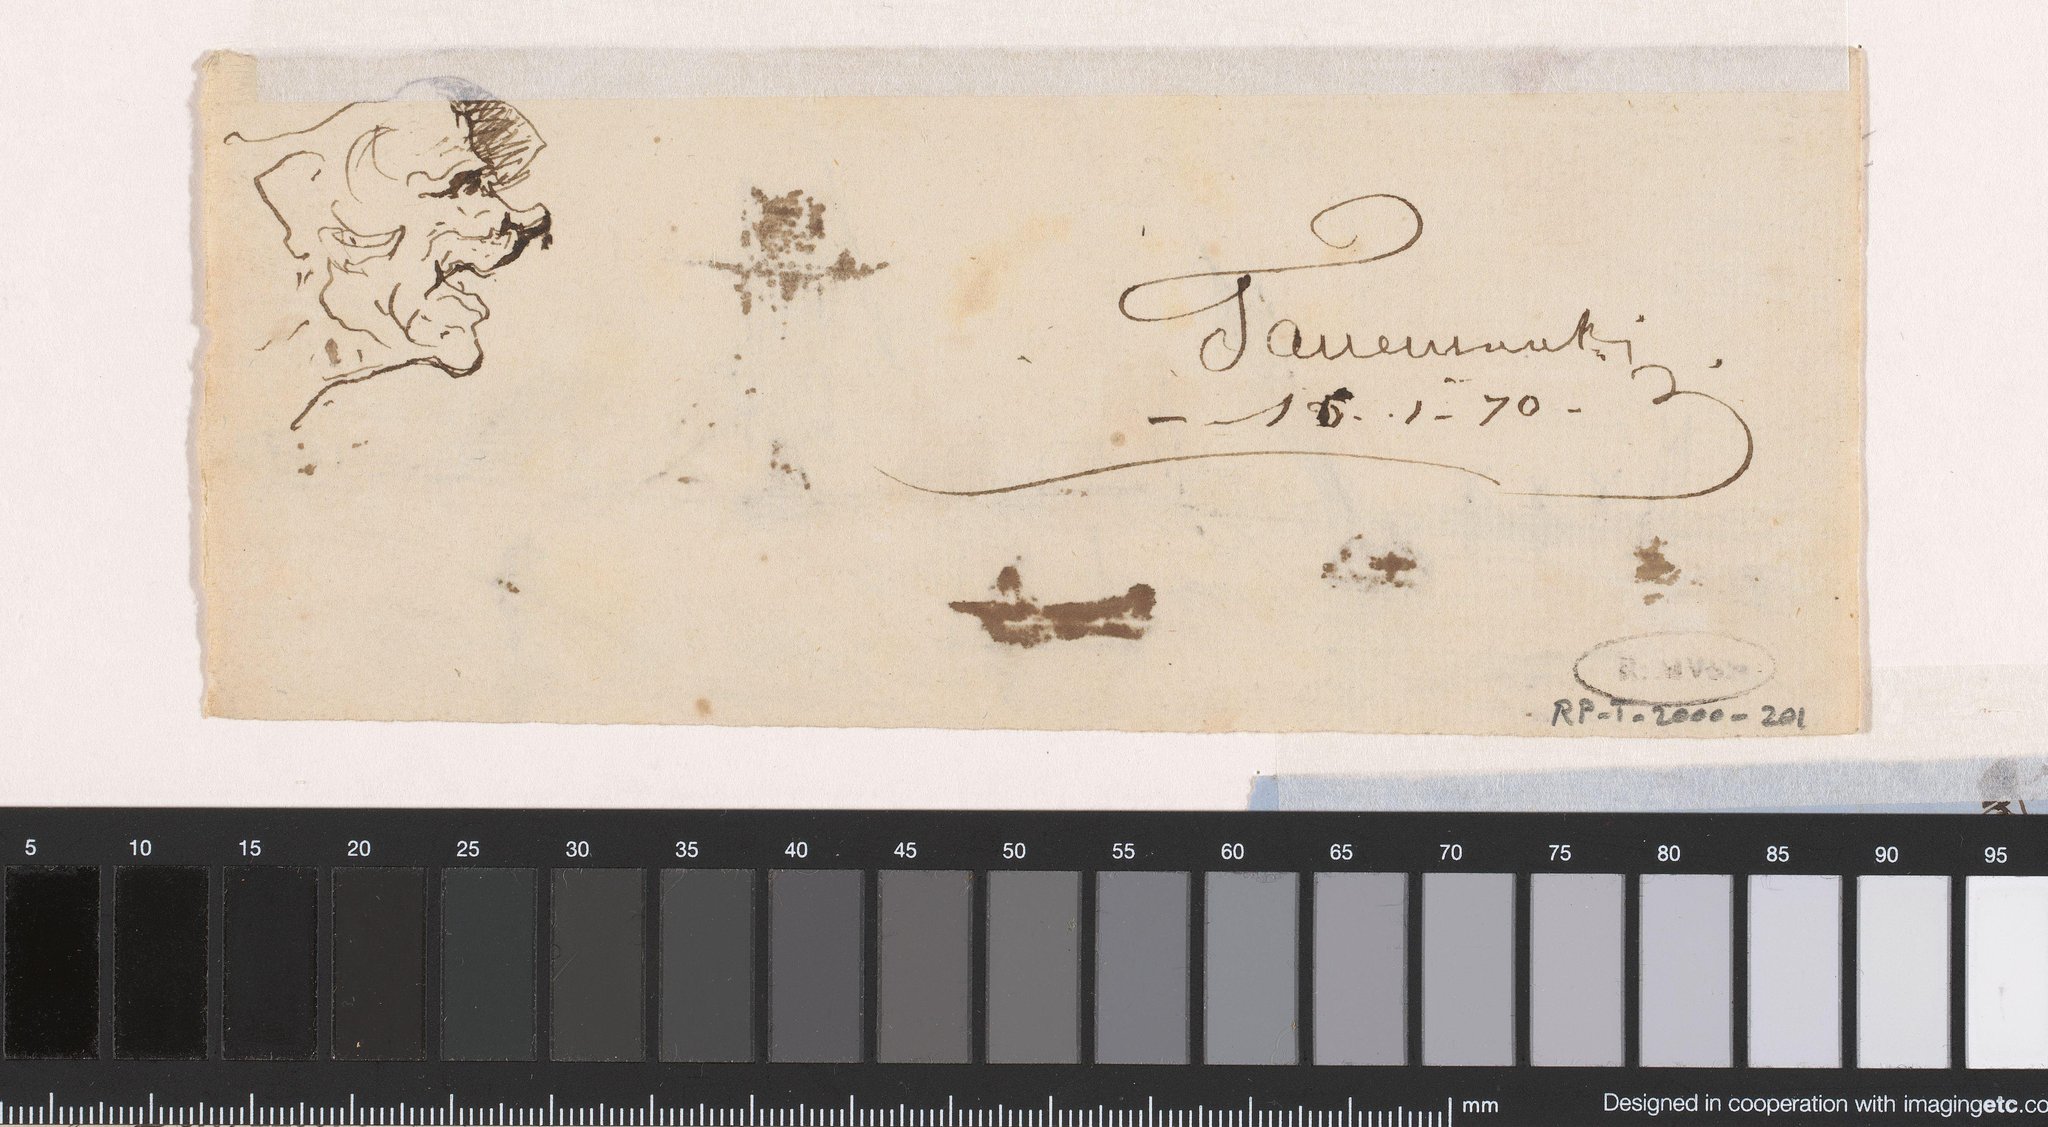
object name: drawing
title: Kop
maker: johannes tavenraat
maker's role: draughtsman, painter, print maker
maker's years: 1809-1881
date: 1870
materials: ink, paper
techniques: pen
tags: caricatures (human types)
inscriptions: collector's mark: Lugt 2228, signature and date: ‘Tavenraat / 16-1-70’